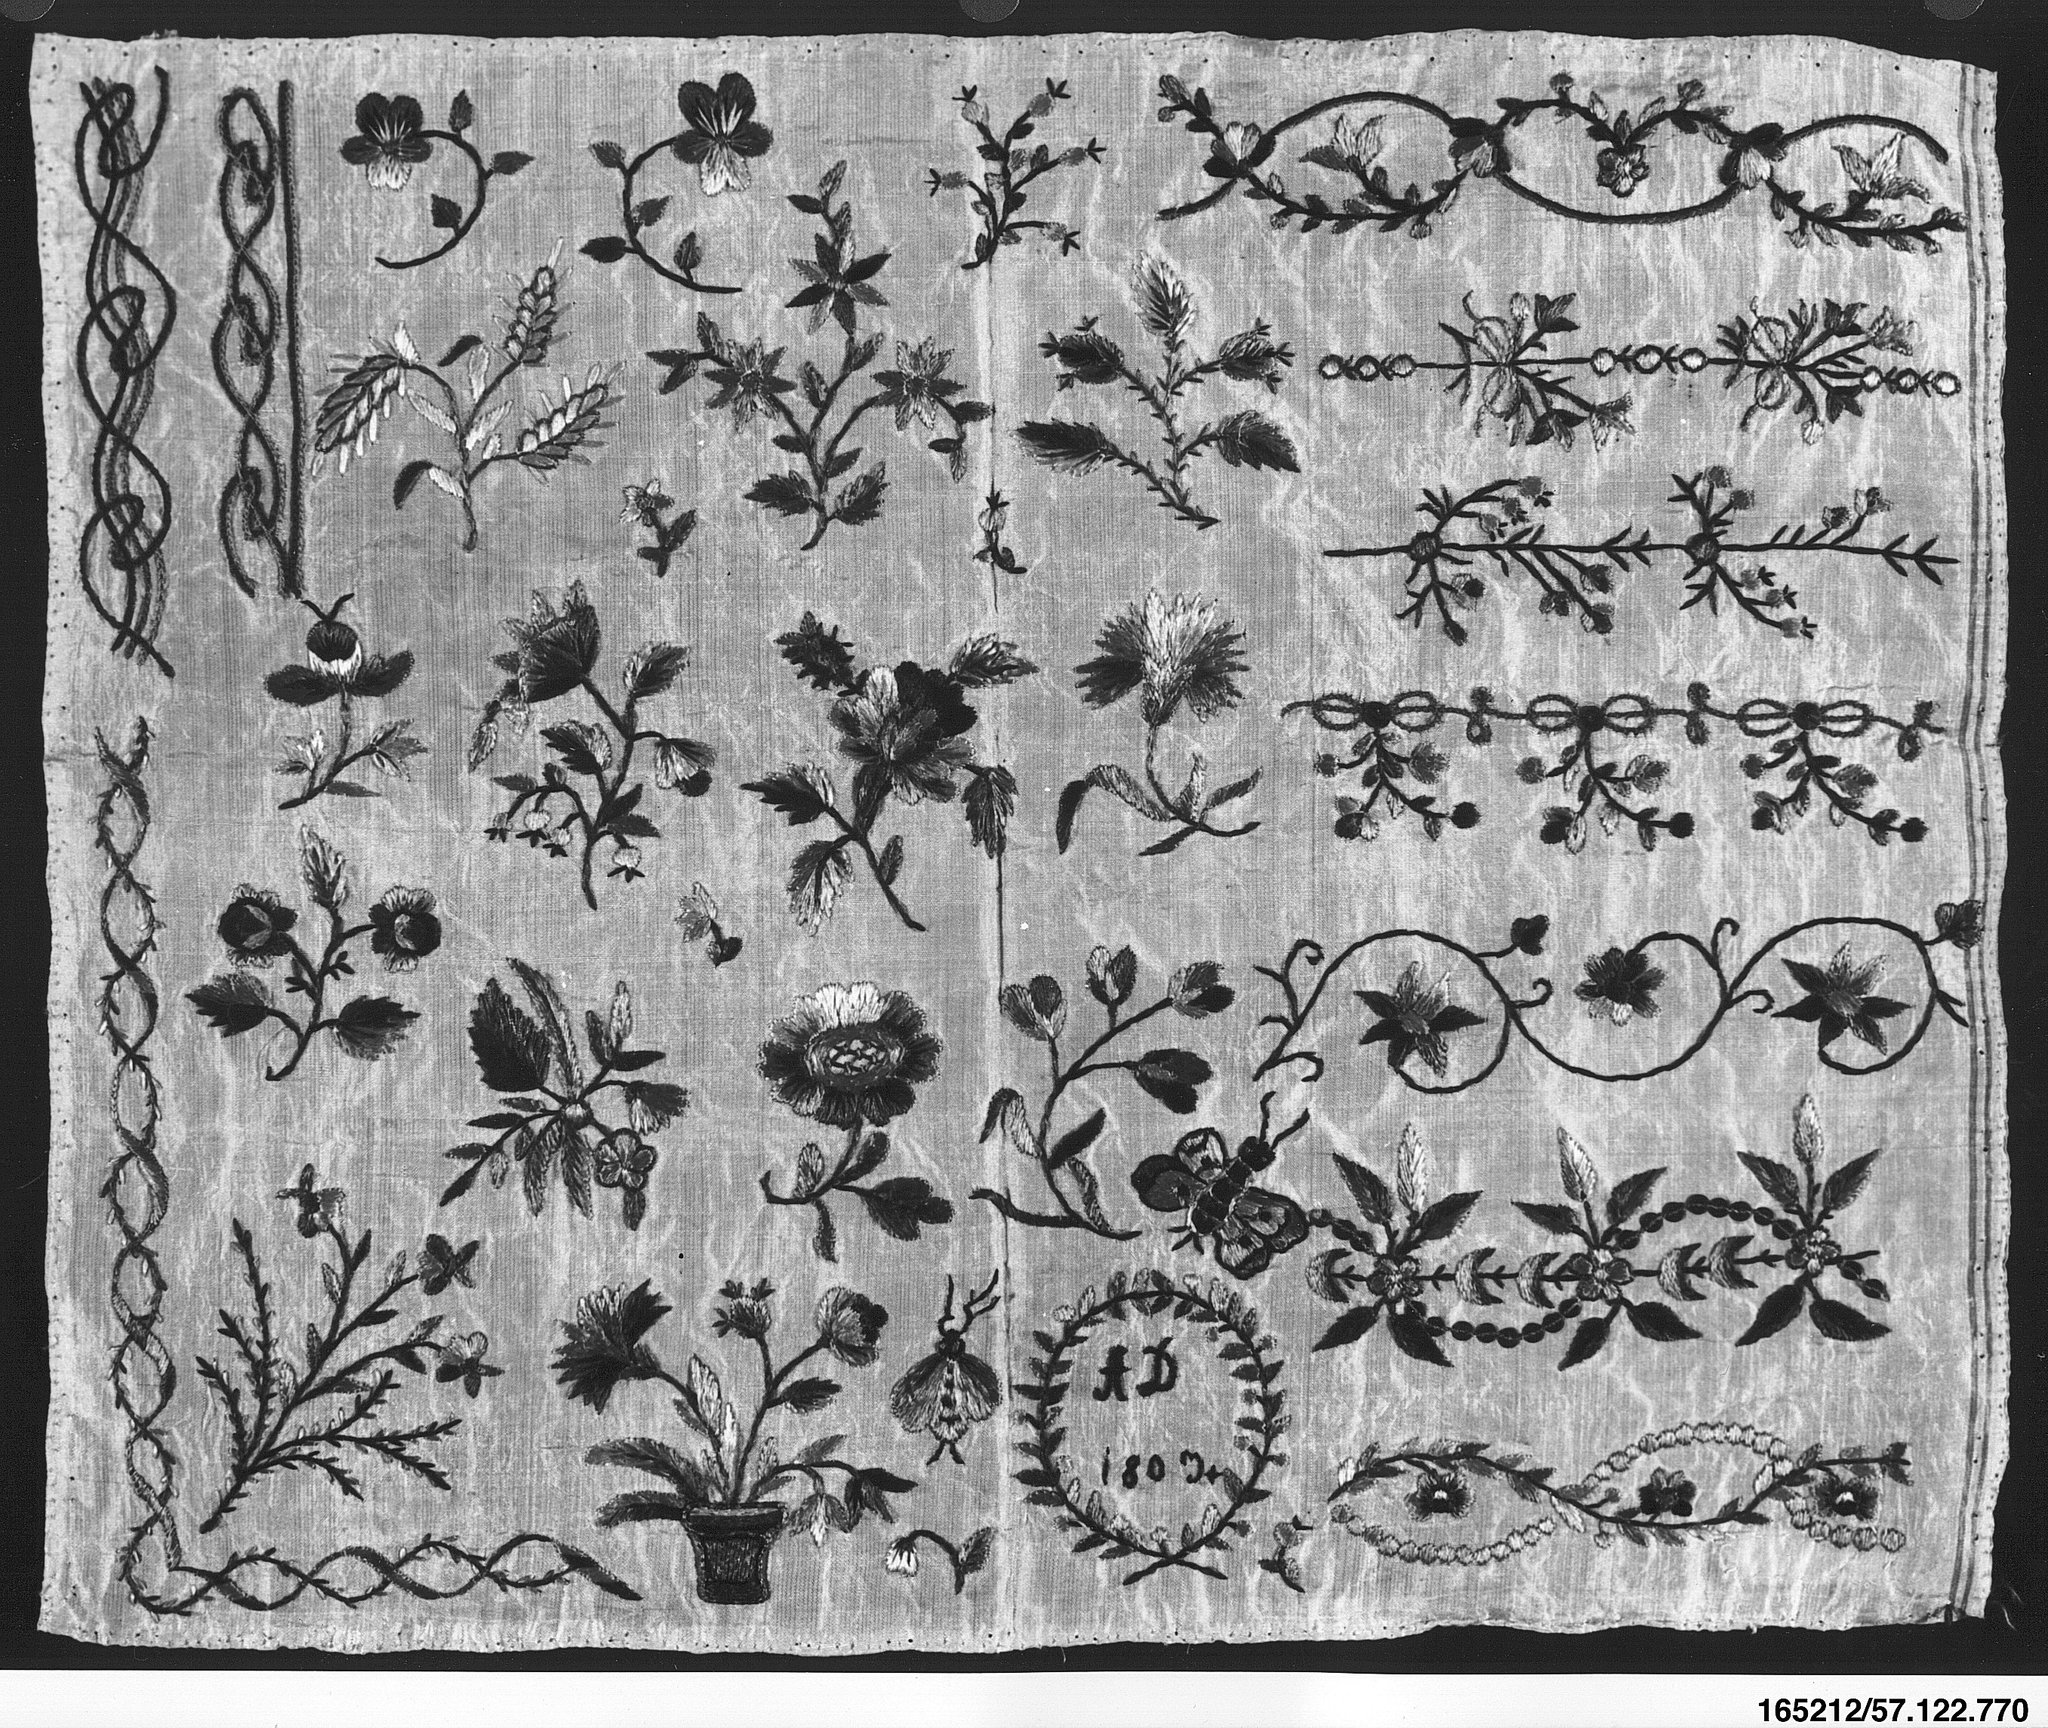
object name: sampler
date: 1803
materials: metal thread, silk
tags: flowers